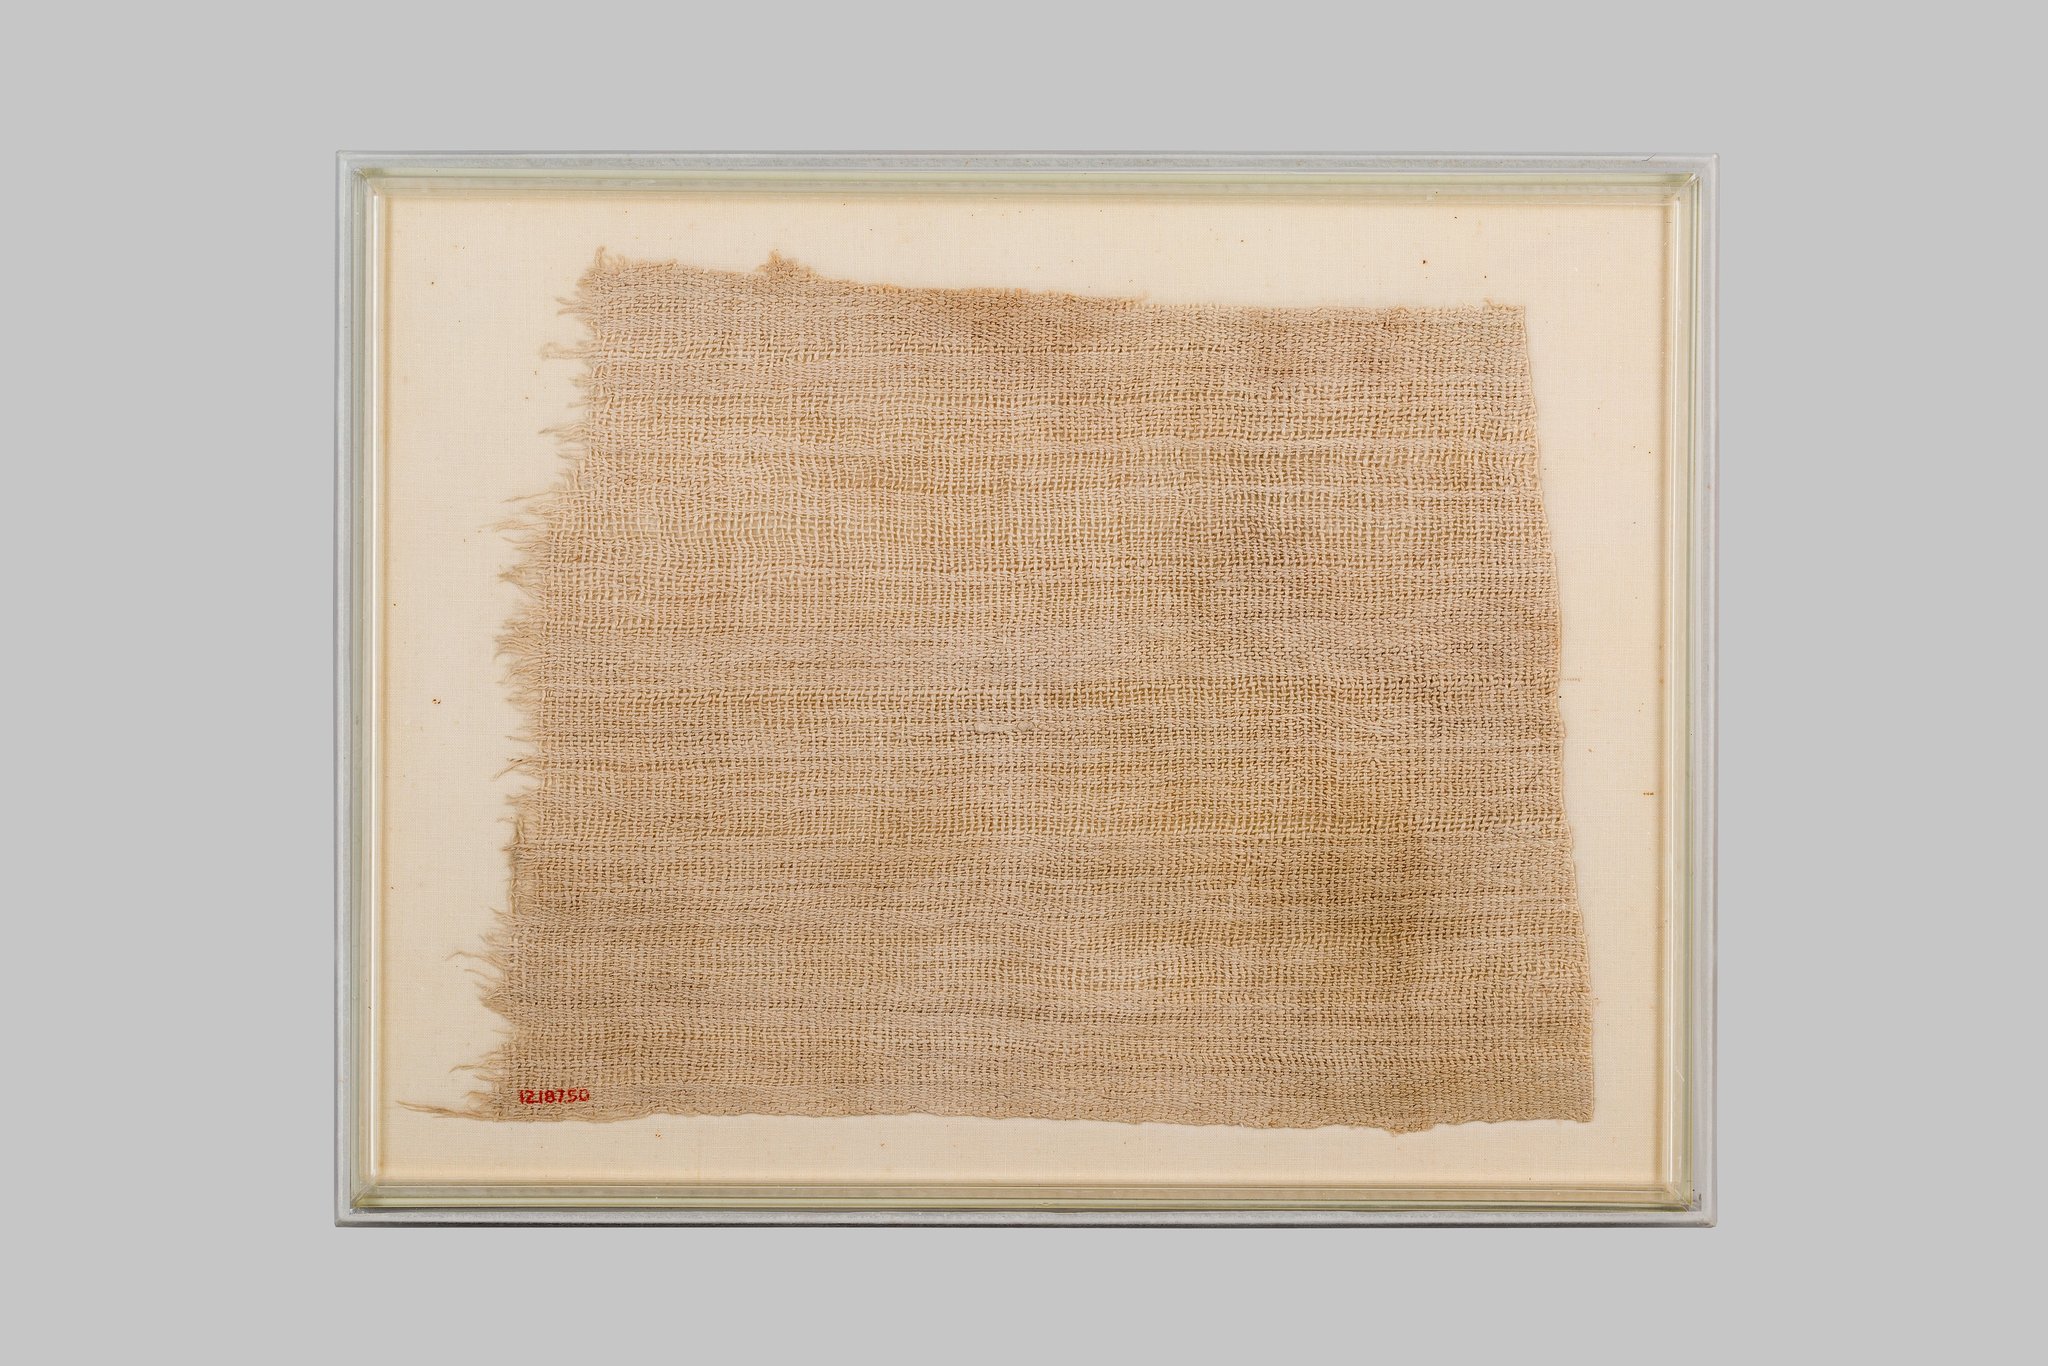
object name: linen cloth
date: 2649-2100 BCE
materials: linen